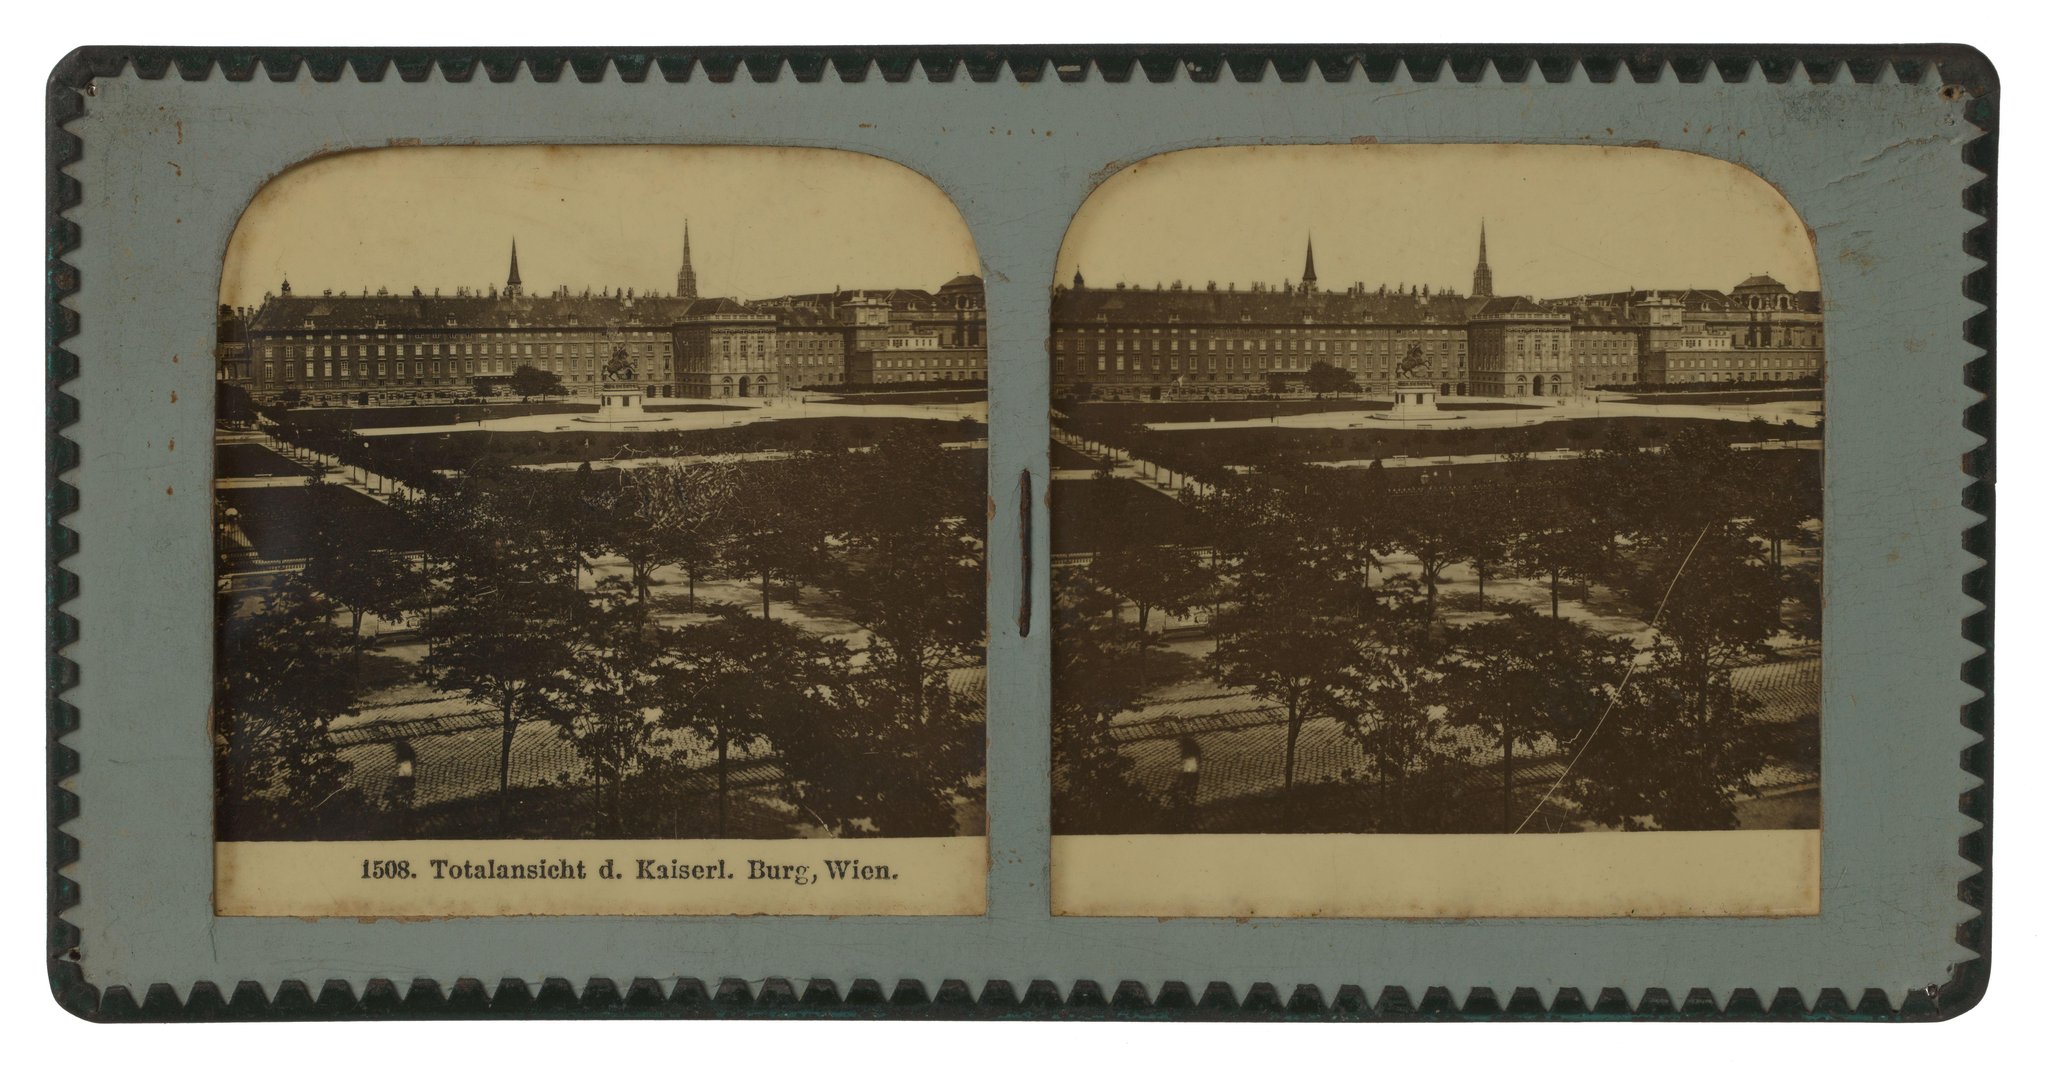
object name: stereograph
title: Gezicht op de linkervleugel van de Hofburg in Wenen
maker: Anonymous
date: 1900-1940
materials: cardboard, film, metal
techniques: gelatin silver print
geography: vienna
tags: palace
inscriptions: number: ‘1508.’